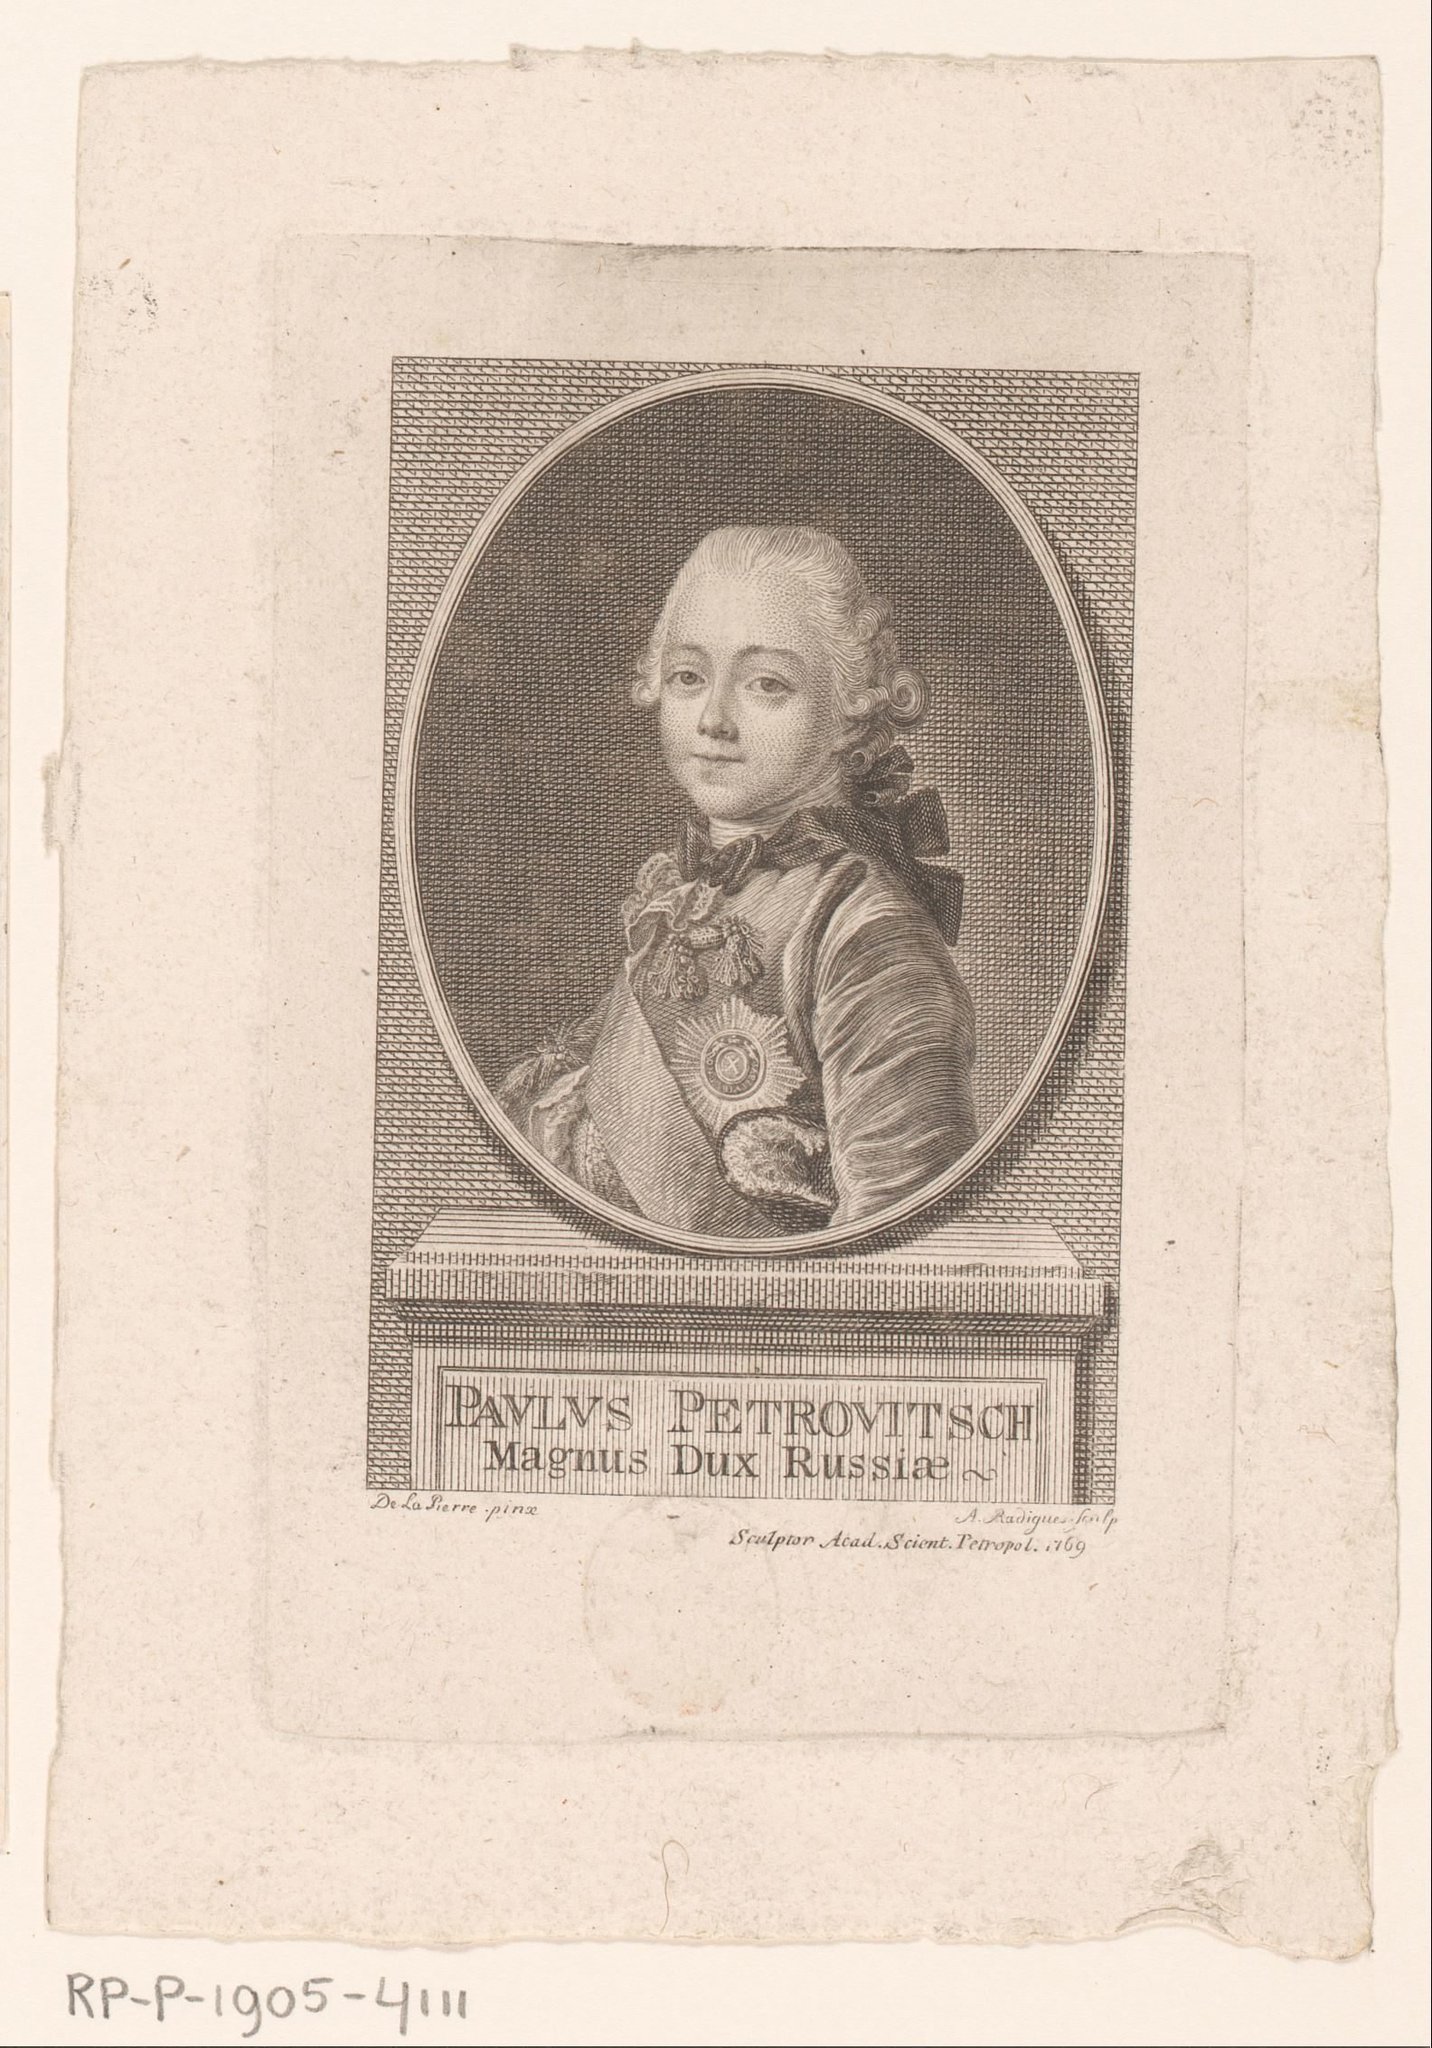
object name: print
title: Portret van Paul I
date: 1769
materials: paper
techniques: engraving, etching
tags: paul i (tsaar van rusland), historical persons, emperor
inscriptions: collector's mark: Lugt 2228, collector's mark: Lugt 6011